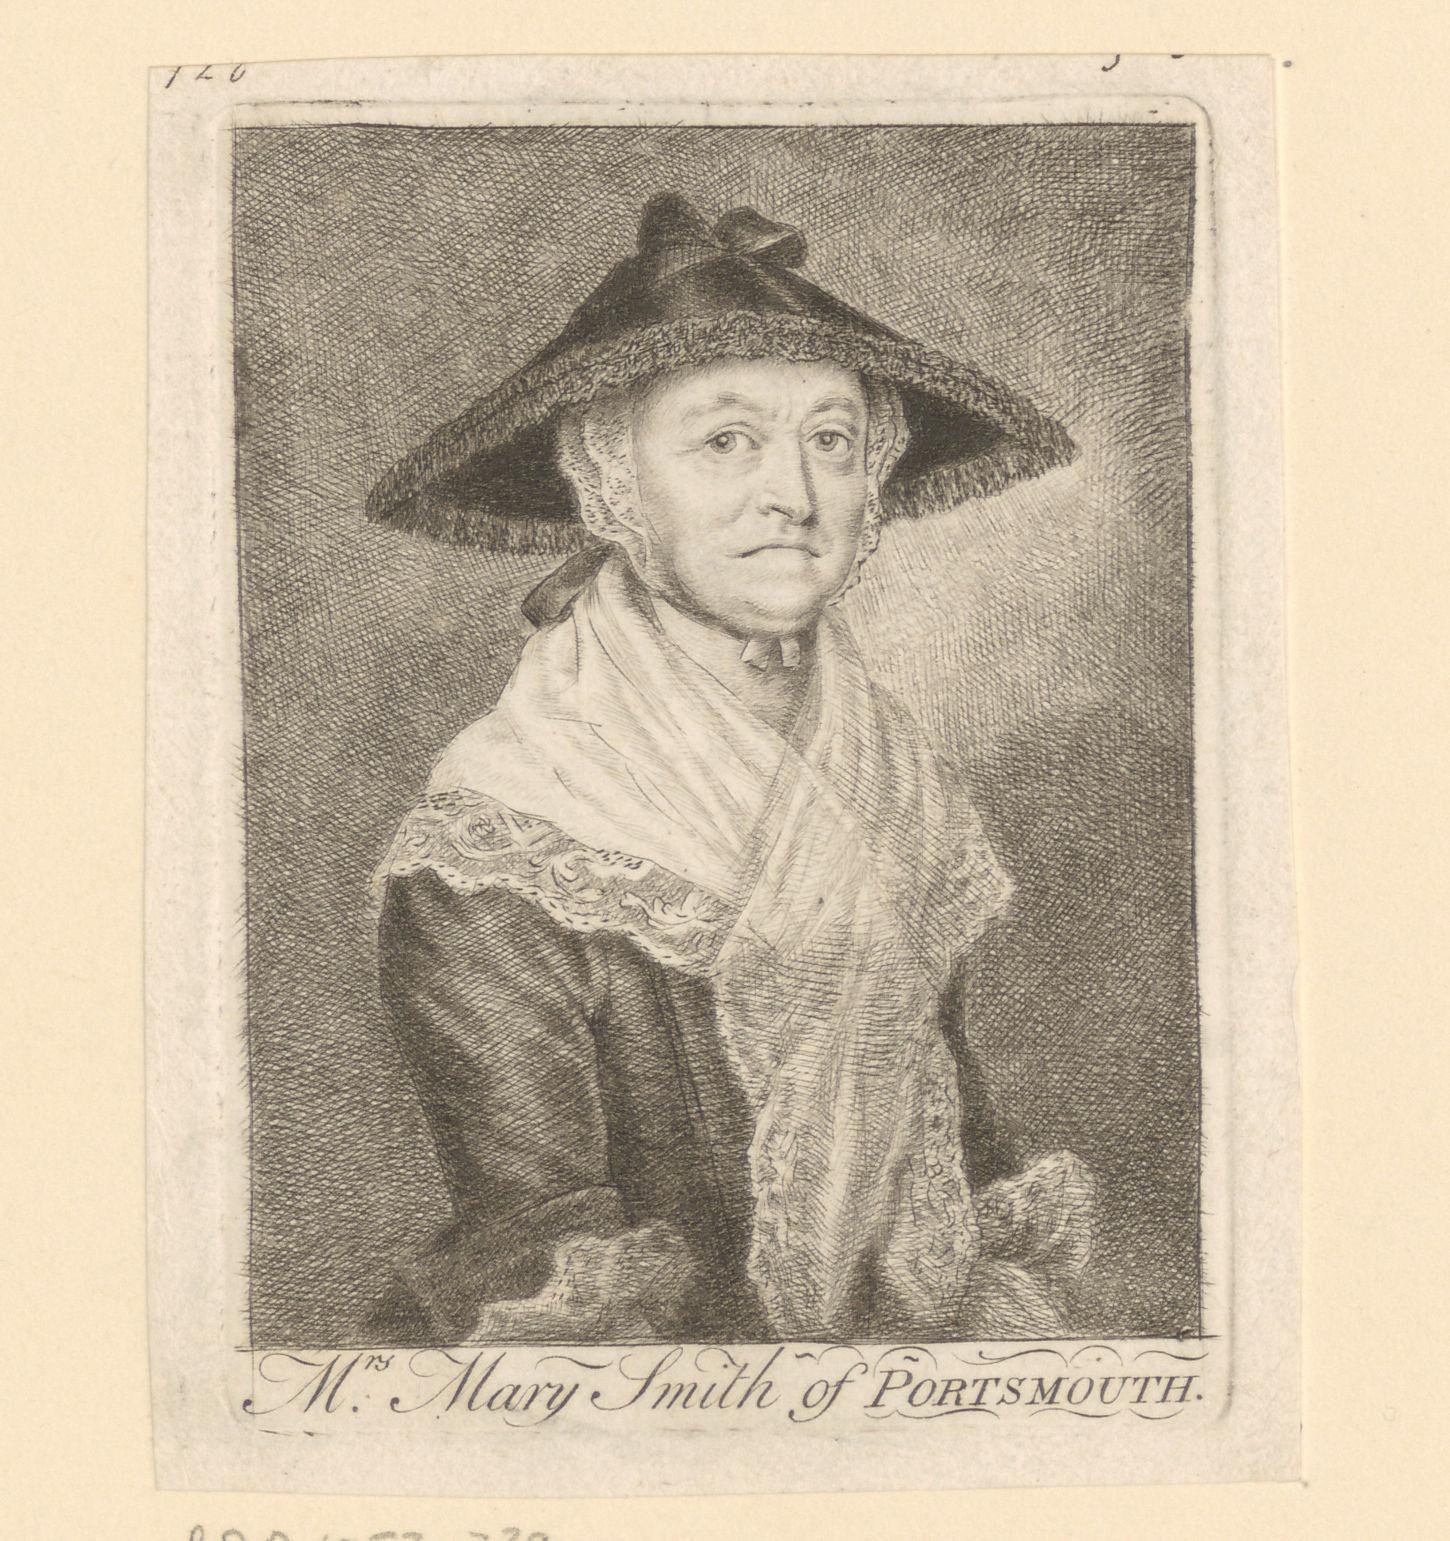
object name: print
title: Portret van Mary Smith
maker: thomas worlidge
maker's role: print maker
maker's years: 1700-1766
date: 1720-1766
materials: paper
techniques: drypoint, etching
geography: london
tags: historical person (with name) - bb - woman - historical person (with name) portrayed alone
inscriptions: collector's mark: Lugt 2228, collector's mark: Lugt 2760